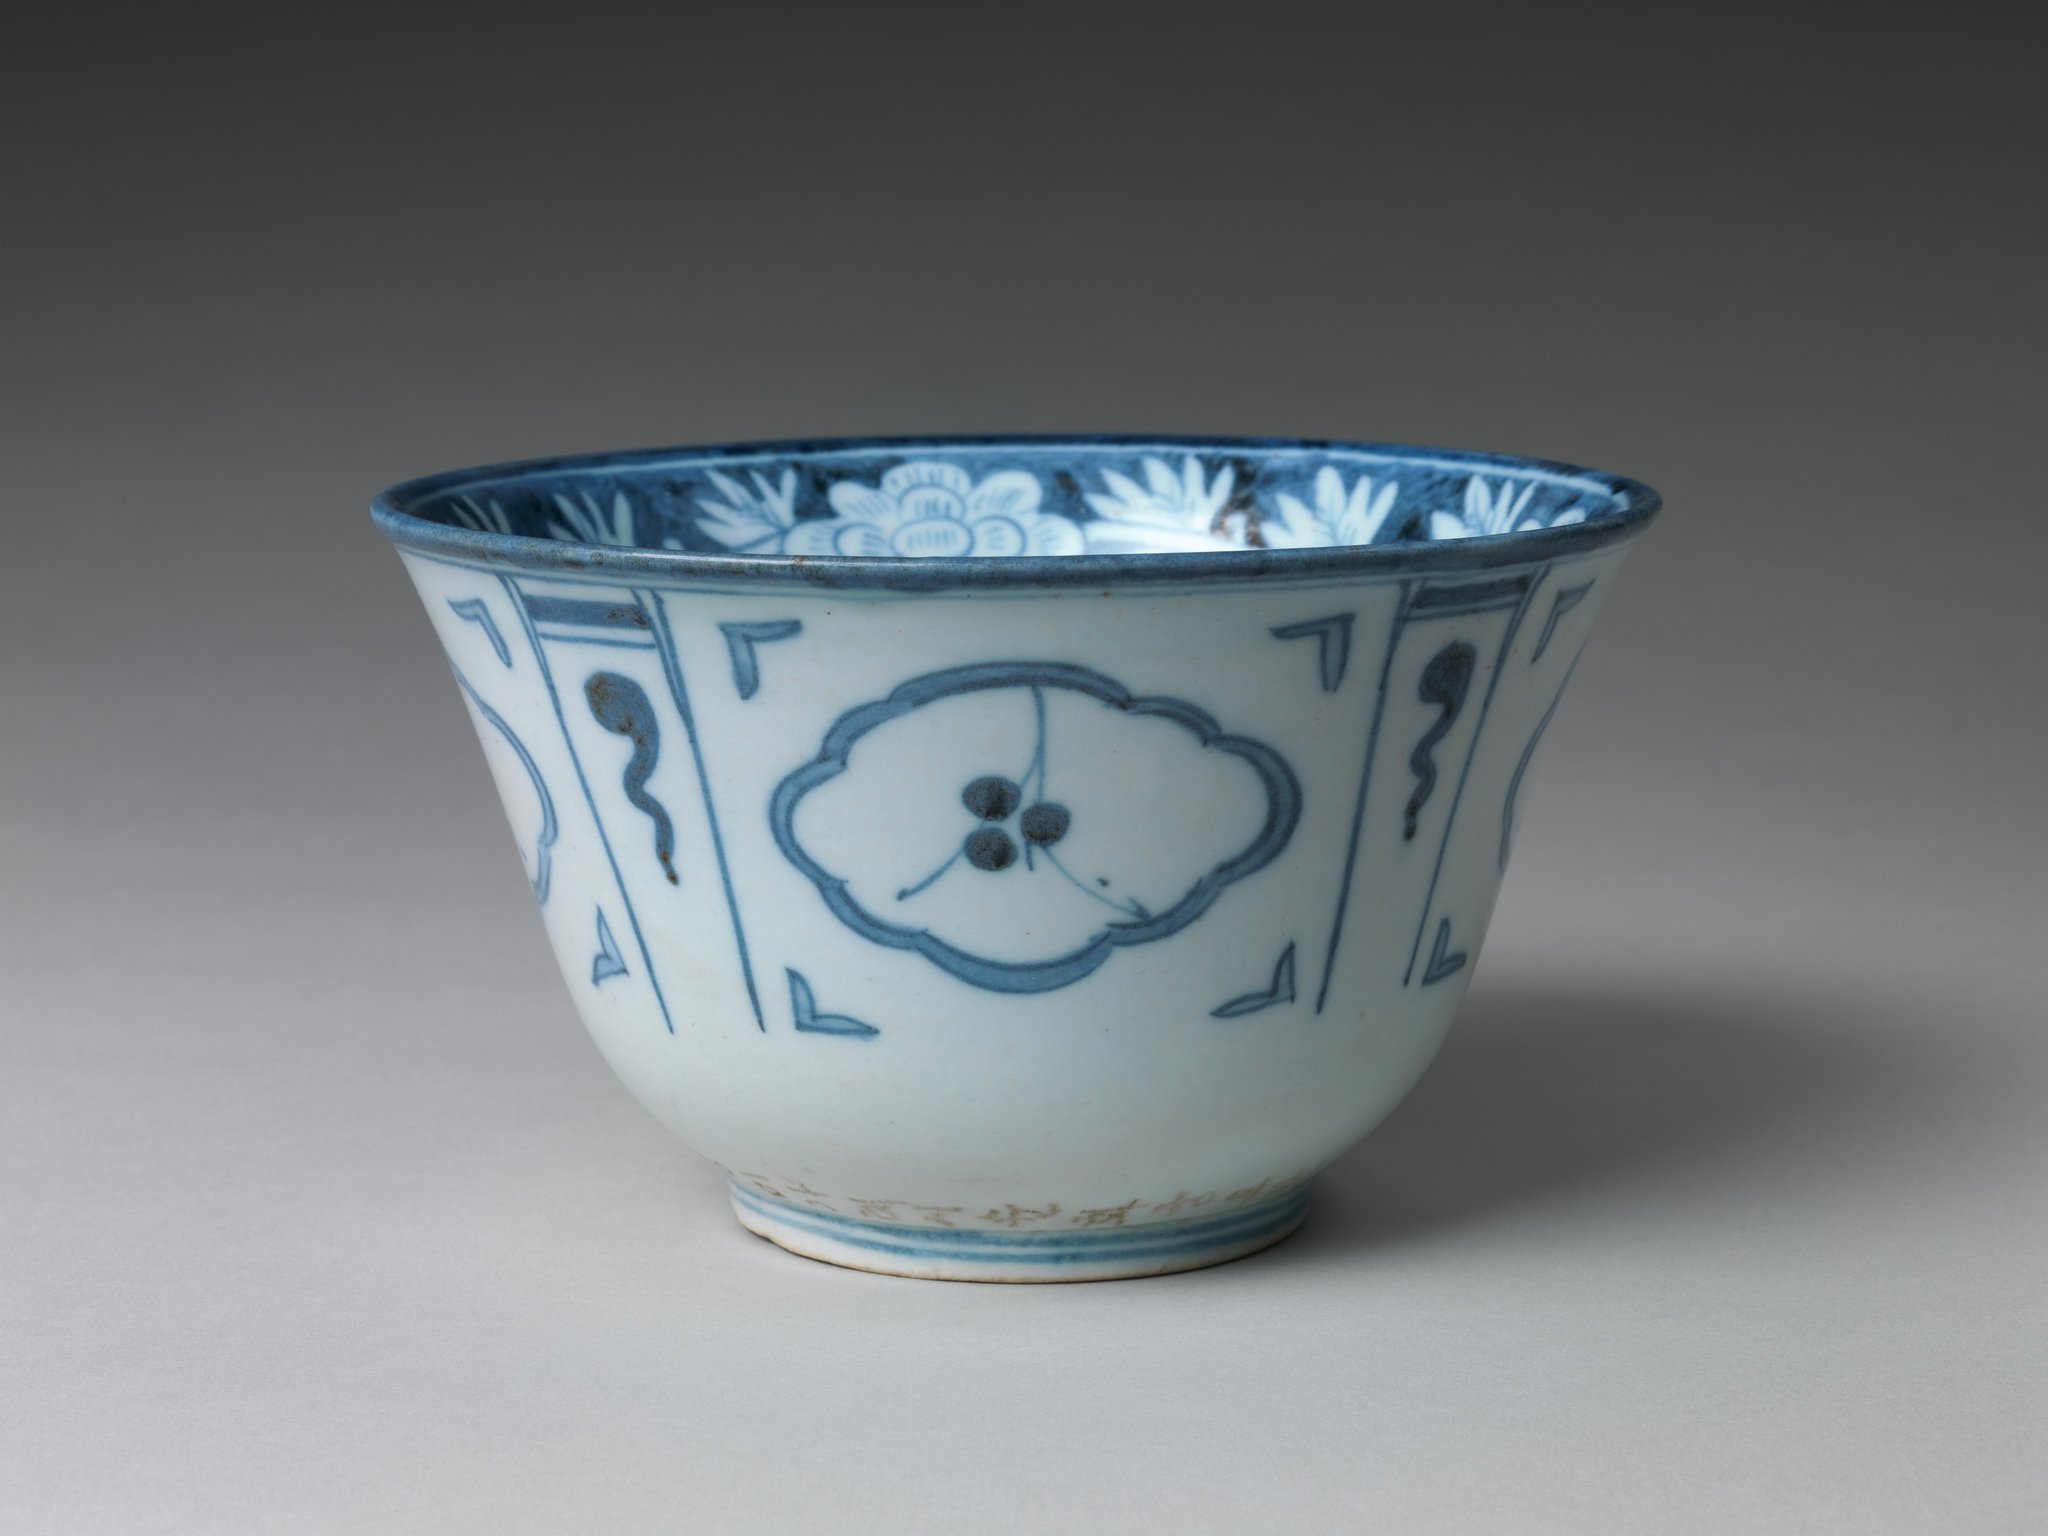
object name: bowl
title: Bowl with floral and abstract motifs and hangeul inscription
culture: korean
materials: cobalt, porcelain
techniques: underglaze